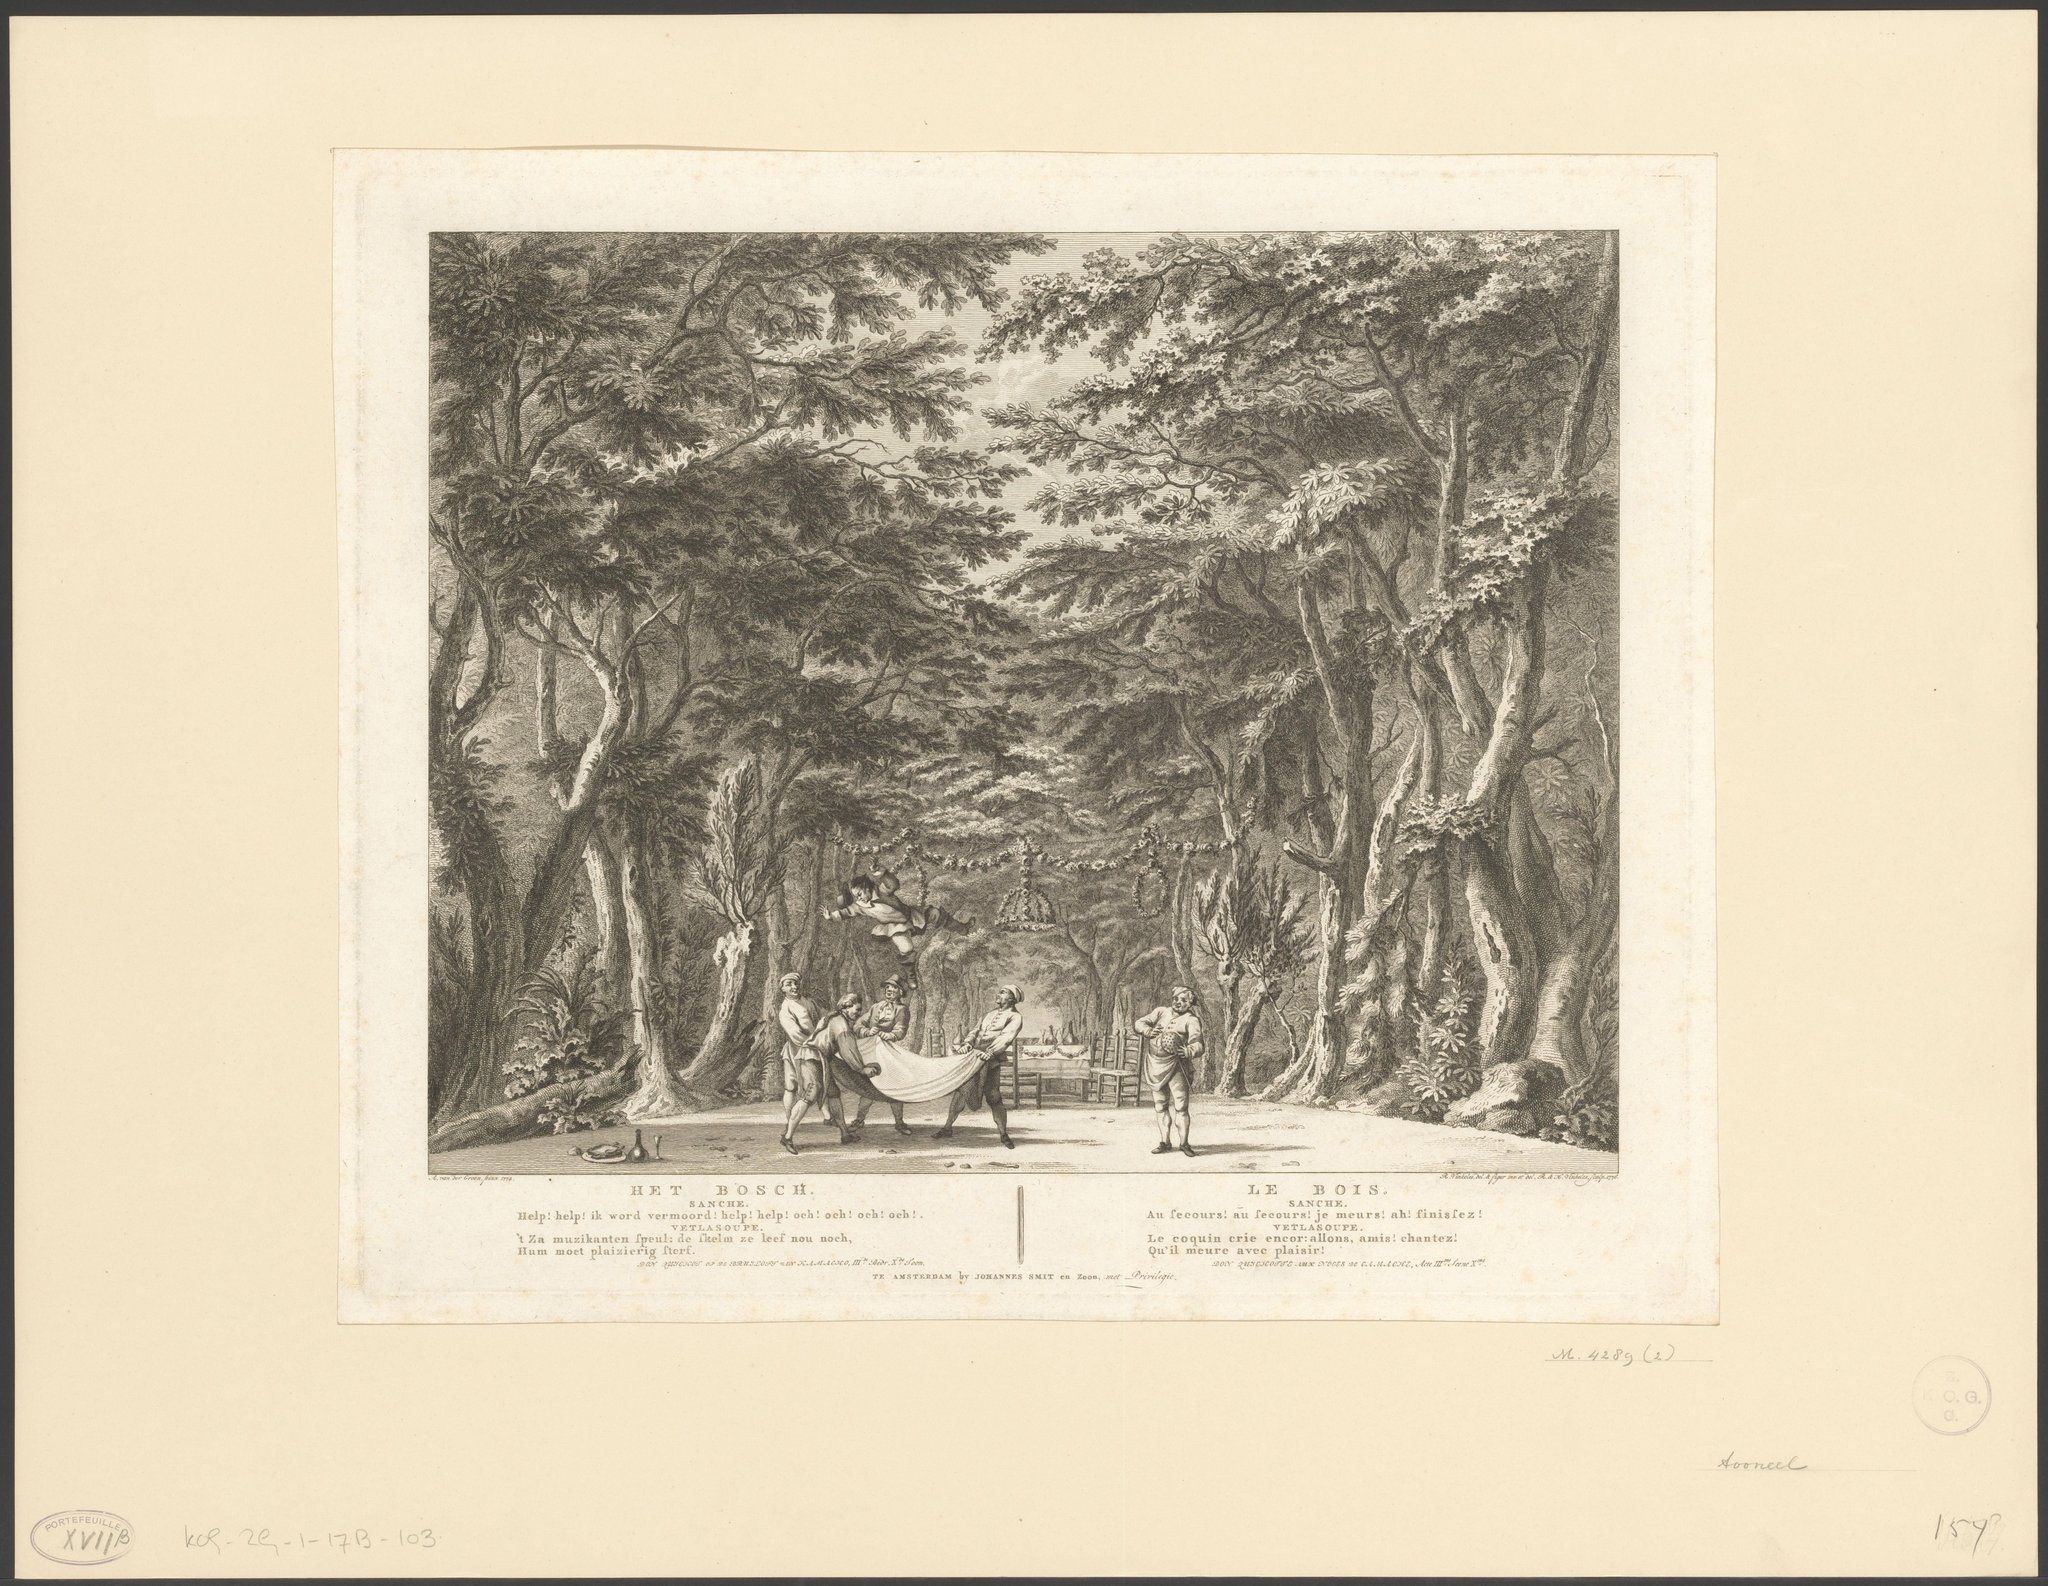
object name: print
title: Het Bosch / Le Bois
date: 1776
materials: paper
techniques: engraving, etching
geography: amsterdam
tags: theatre, theatrical performance, stage design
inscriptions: stamp, collector's mark: Lugt 1641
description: Het coulissendecor Het Bosch, met een scène uit: Don Quichot. Onderdeel van een serie van zes toneeldecors van toneelstukken opgevoerd in de nieuwe Amsterdamse Schouwburg uit de jaren 1775-1777. Onderwerpsrubrieken binnen de Atlas Zeden en Gewoonten: Schoone kunsten, Tooneel, Decors voor de Schouwburg.